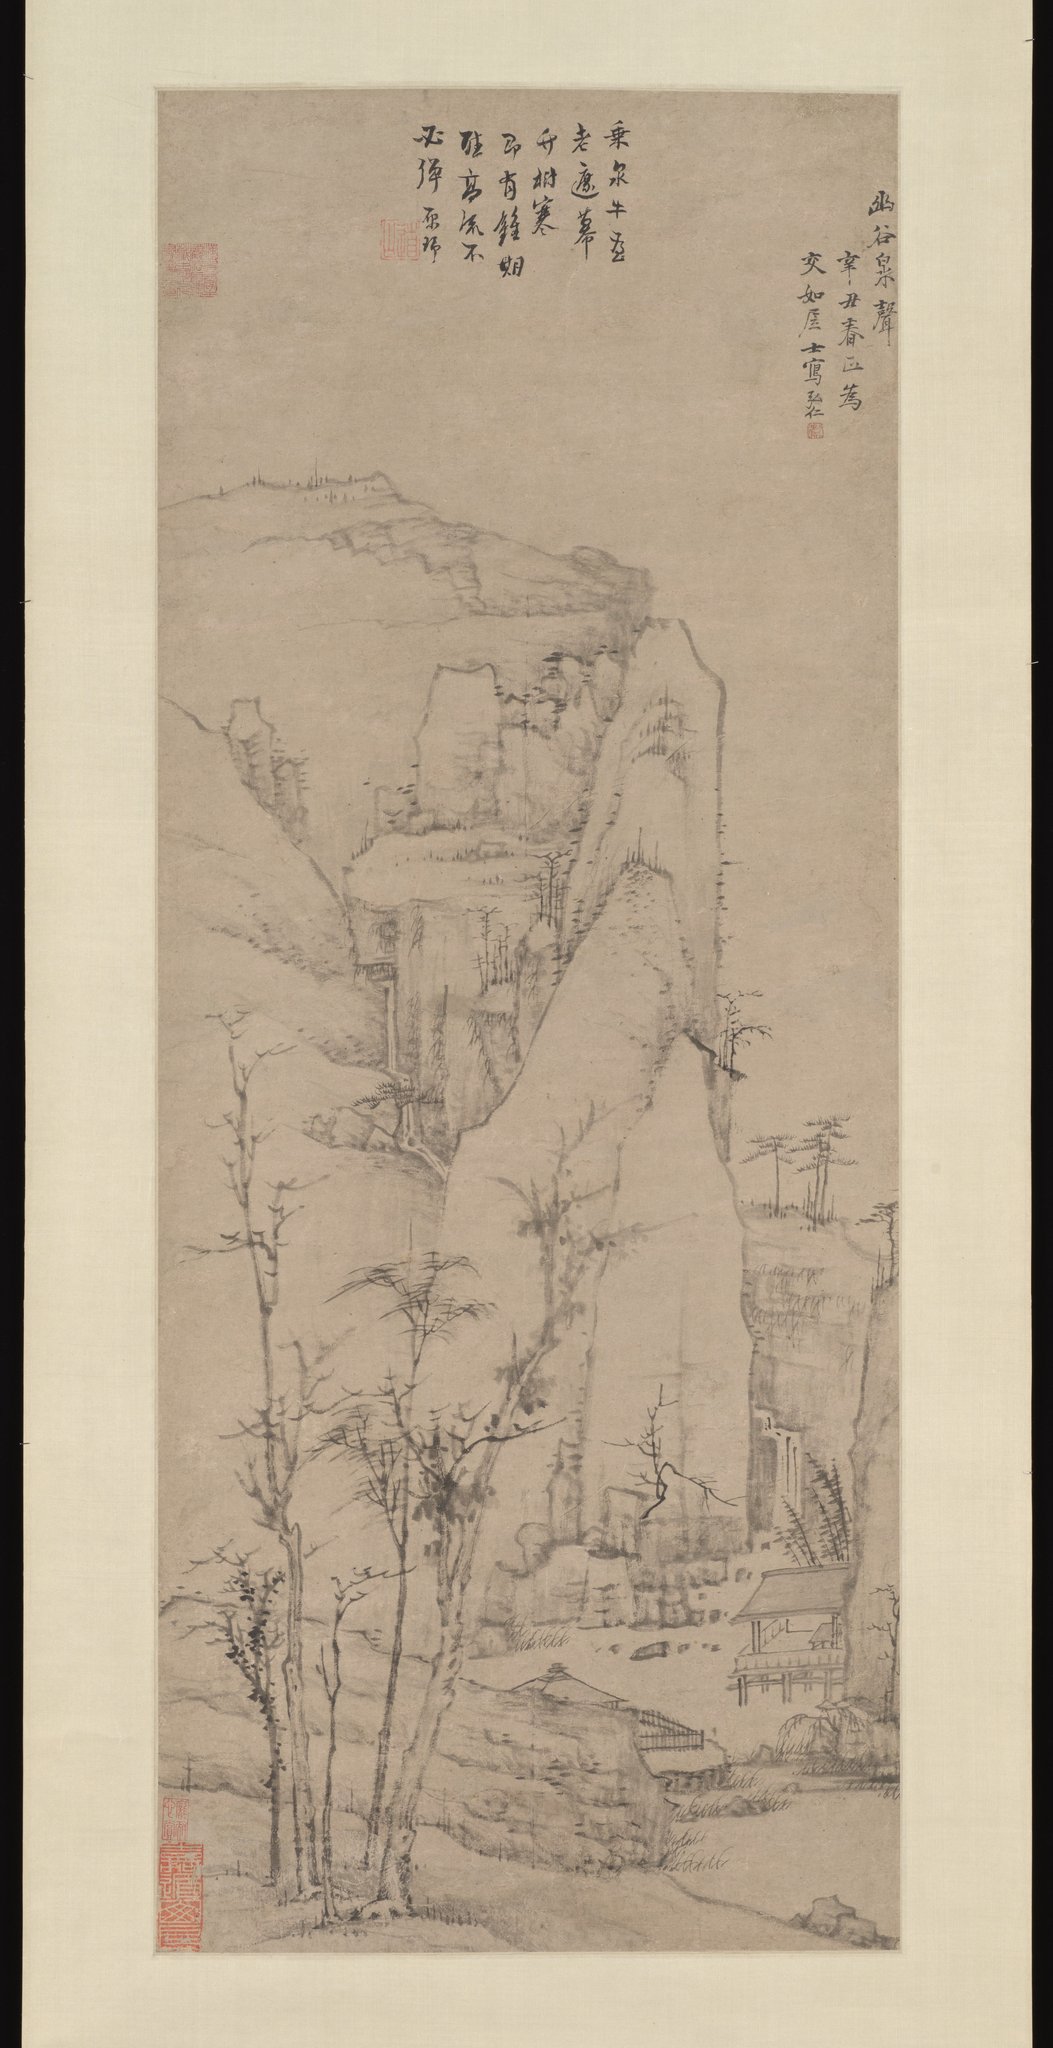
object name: hanging scroll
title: The Sound of Spring in a Lonely Valley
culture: chinese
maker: hongren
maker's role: artist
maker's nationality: chinese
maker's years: 1610-1664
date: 1661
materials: ink, paper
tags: landscapes